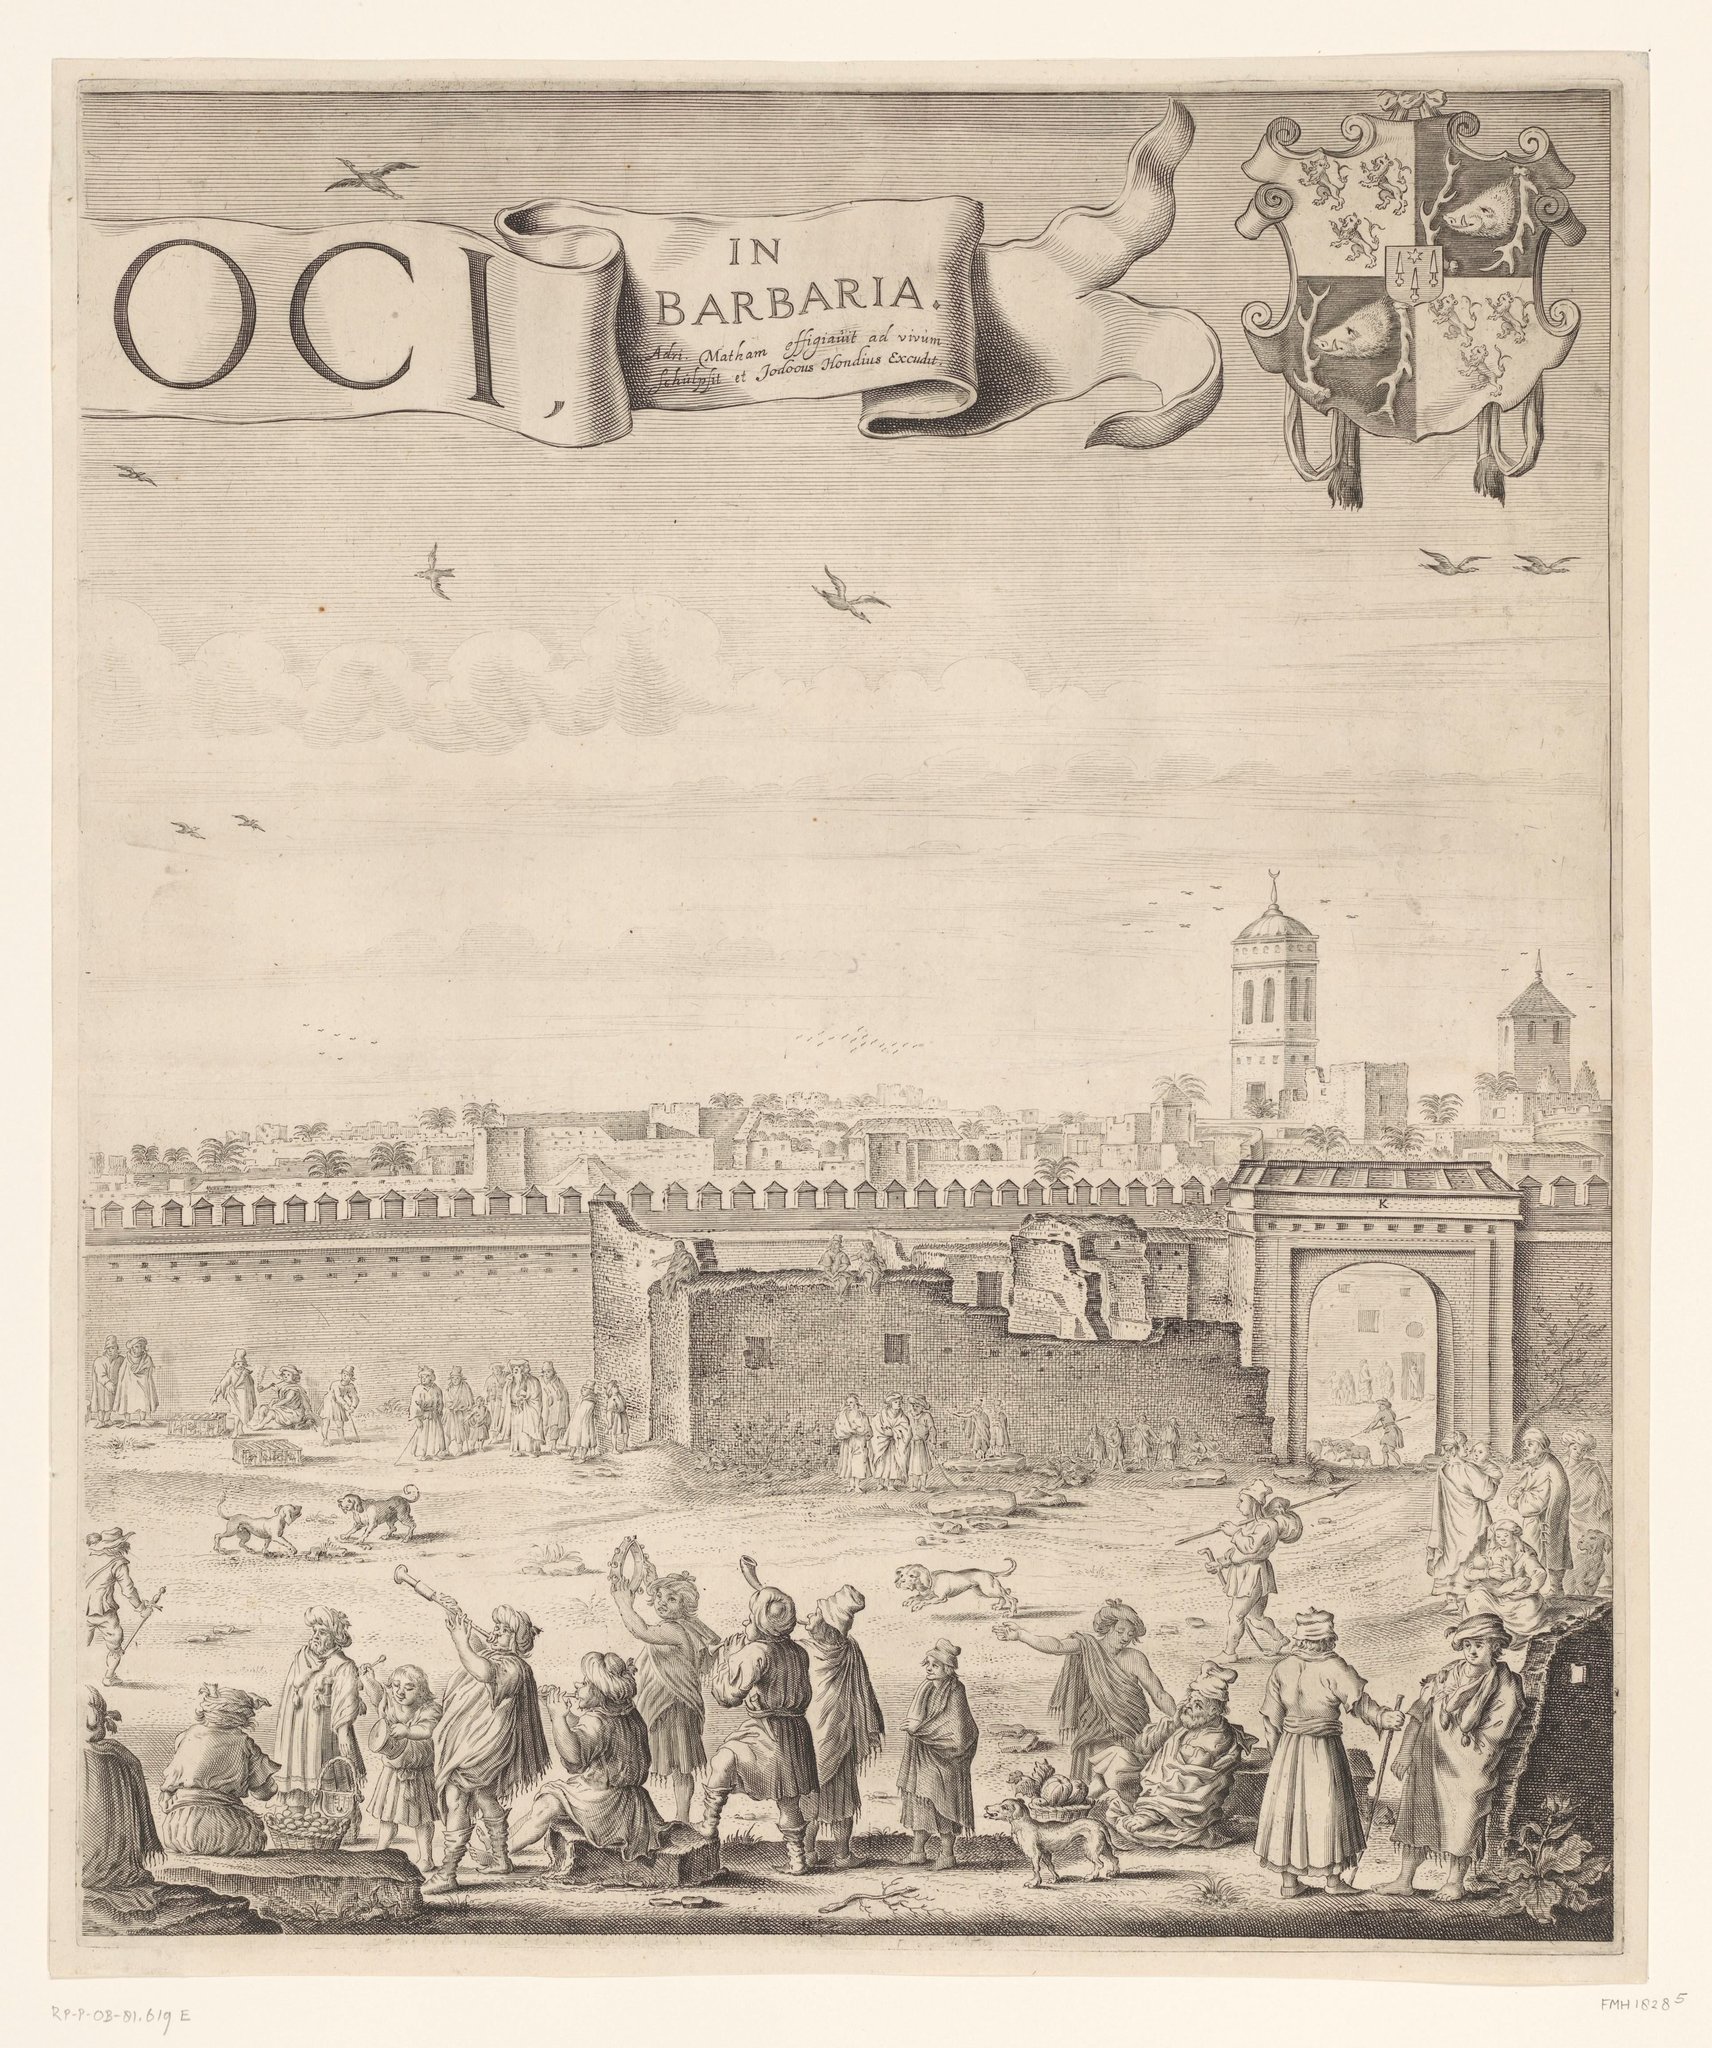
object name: print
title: Palatium Magni Regis Maroci, in Barbaria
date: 1646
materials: paper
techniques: engraving, etching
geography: the hague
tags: palace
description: Gezicht op het paleis van de sultan van Marokko in Marrakesh, ten tijde van het bezoek door het gezantschap op een handelsmissie namens de Staten-Generaal onder leiding van Antonius de Liedekercke, van november 1640 tot april 1641. Het paleis (waarschijnlijk het paleis El-Badi) van de sultan Mohammed esh Sheikh es Seghir (op de prent aangeduid als Muley Hamet). Vijfde plaat in een ongemonteerd ensemble bestaande uit vijf prenten en 4 tekstbladen. Bovenaan een cartouche met het wapen van Liedekercke en het laatste deel van de banderol met de titel; op de voorgrond leden van de lokale bevolking en straatmuzikanten.